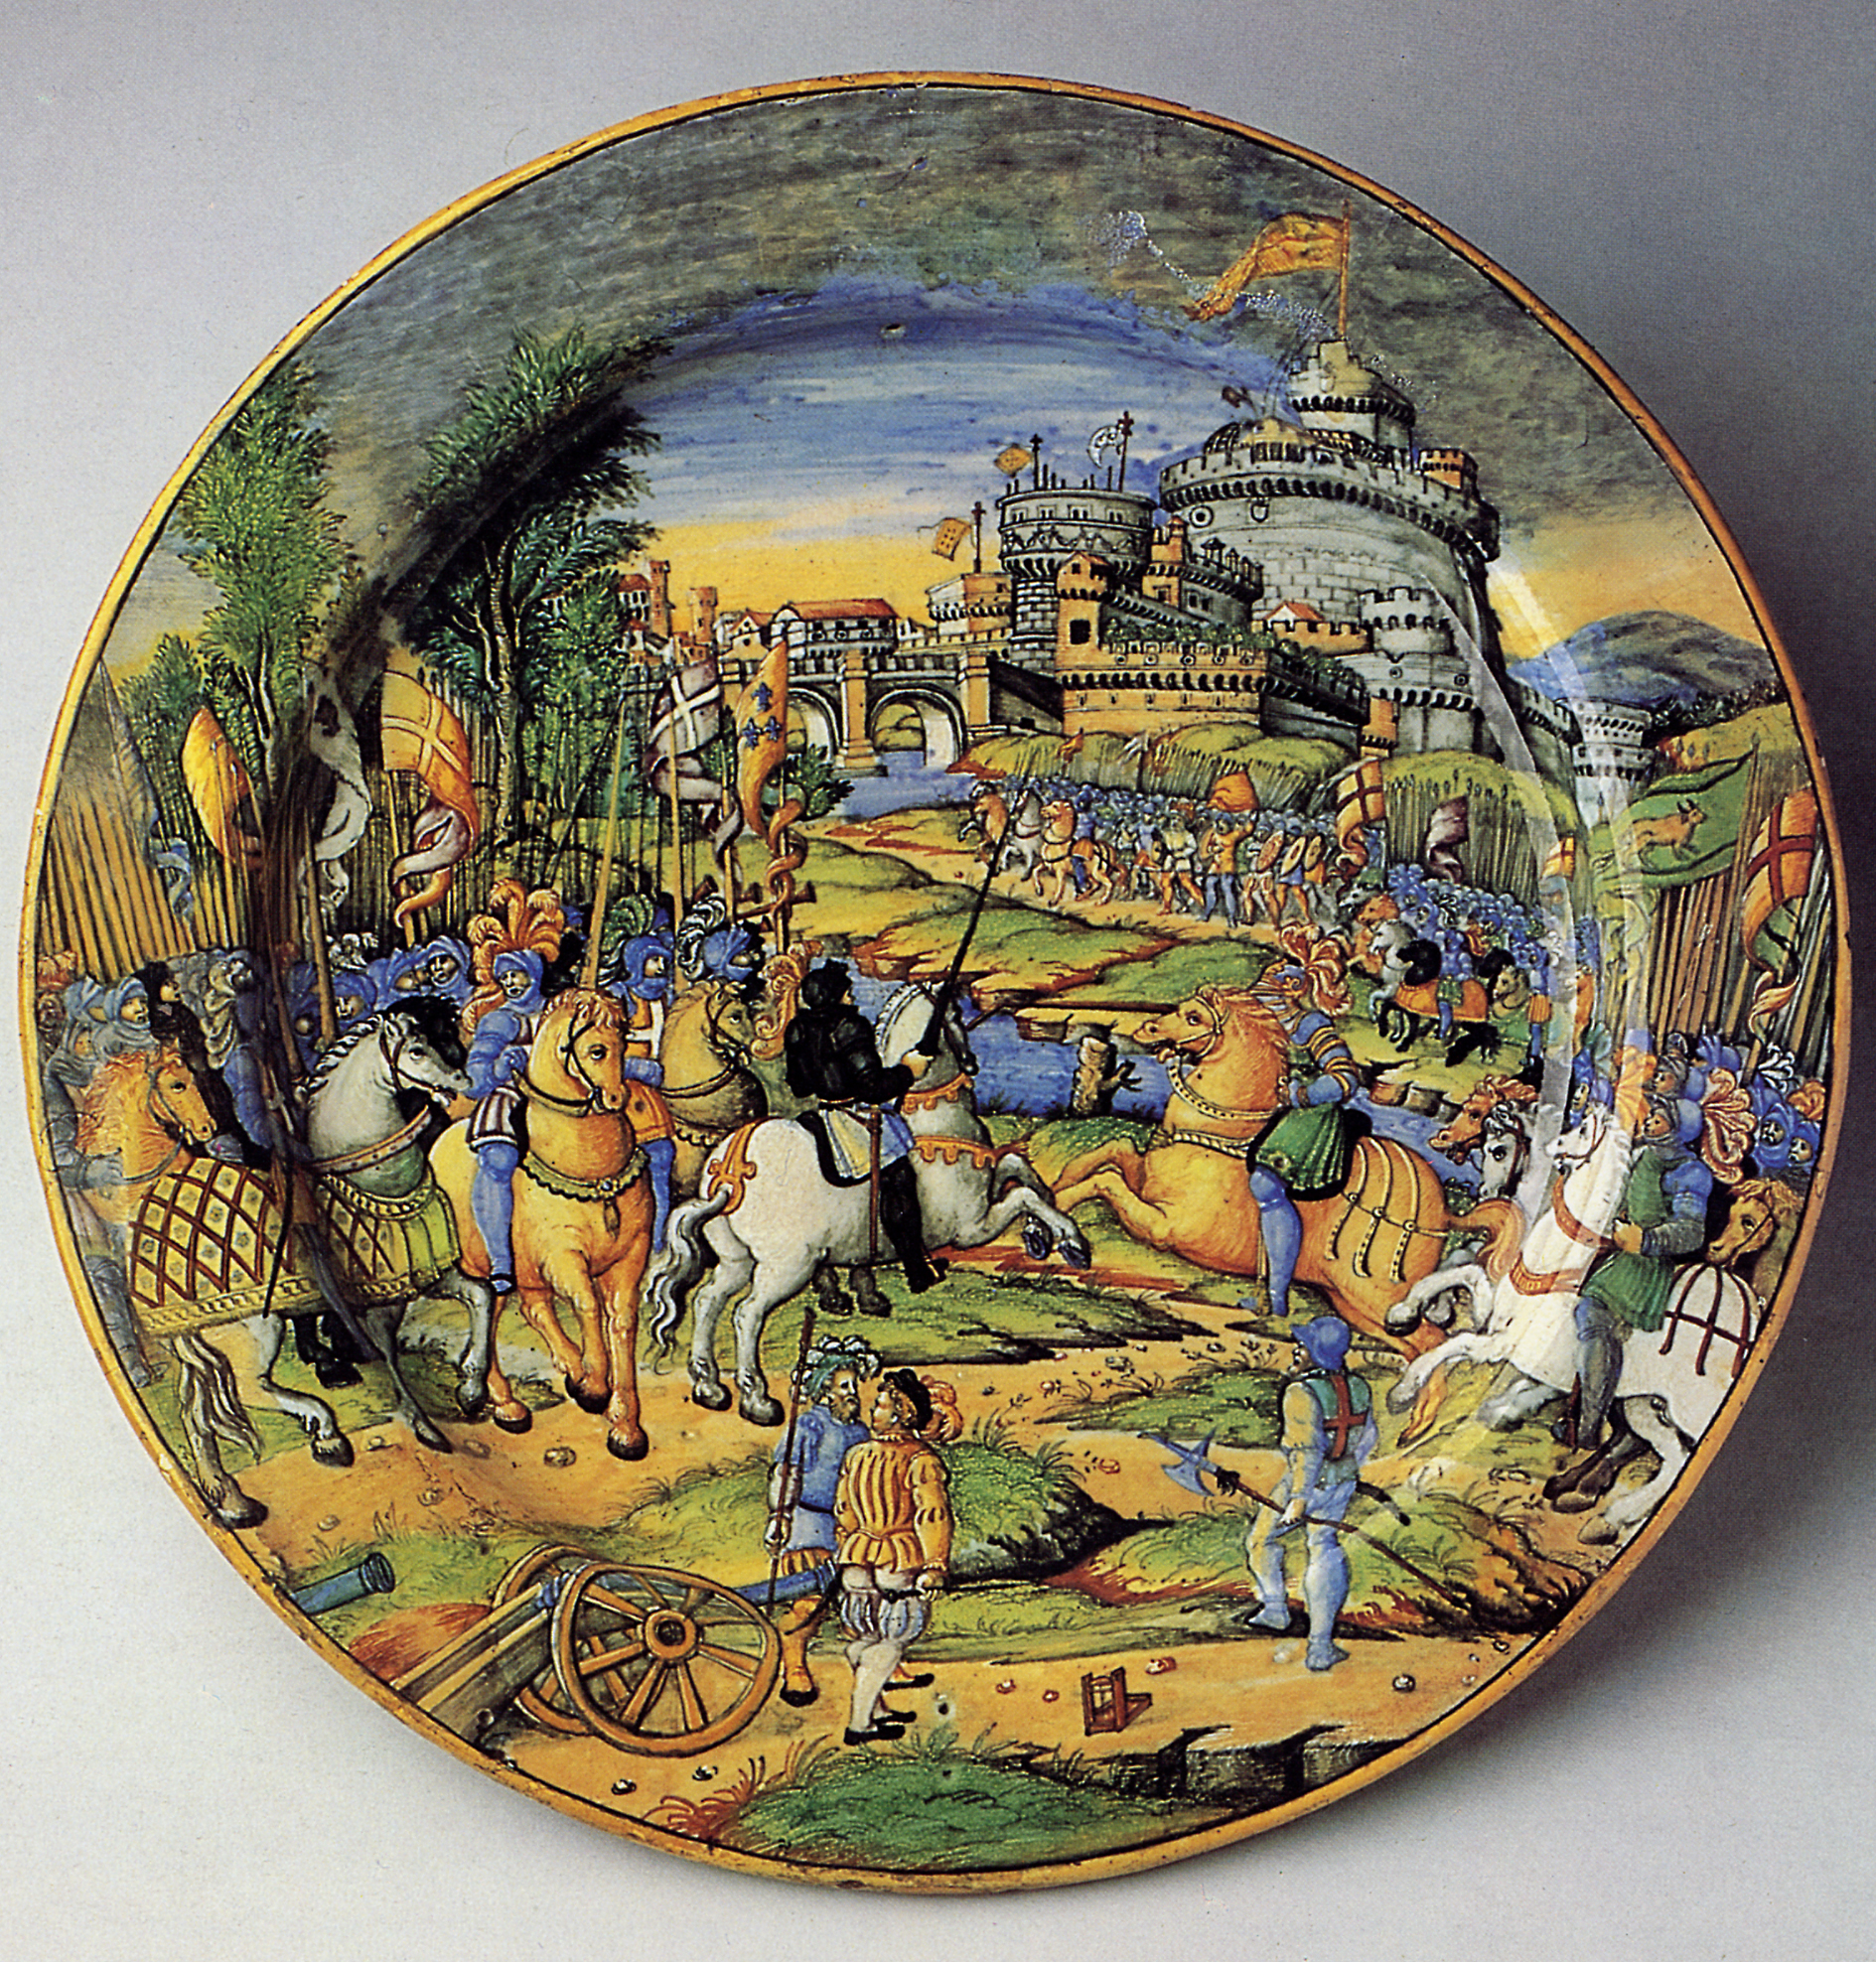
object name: plate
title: Large plate (grande piatto): An episode from the Sack of Rome, 1527: the assault on the Borgo (?)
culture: italian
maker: workshop of guido durantino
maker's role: artist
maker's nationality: italian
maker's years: 1516-1581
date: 1540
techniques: maiolica, glazing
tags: battles,soldiers,horses